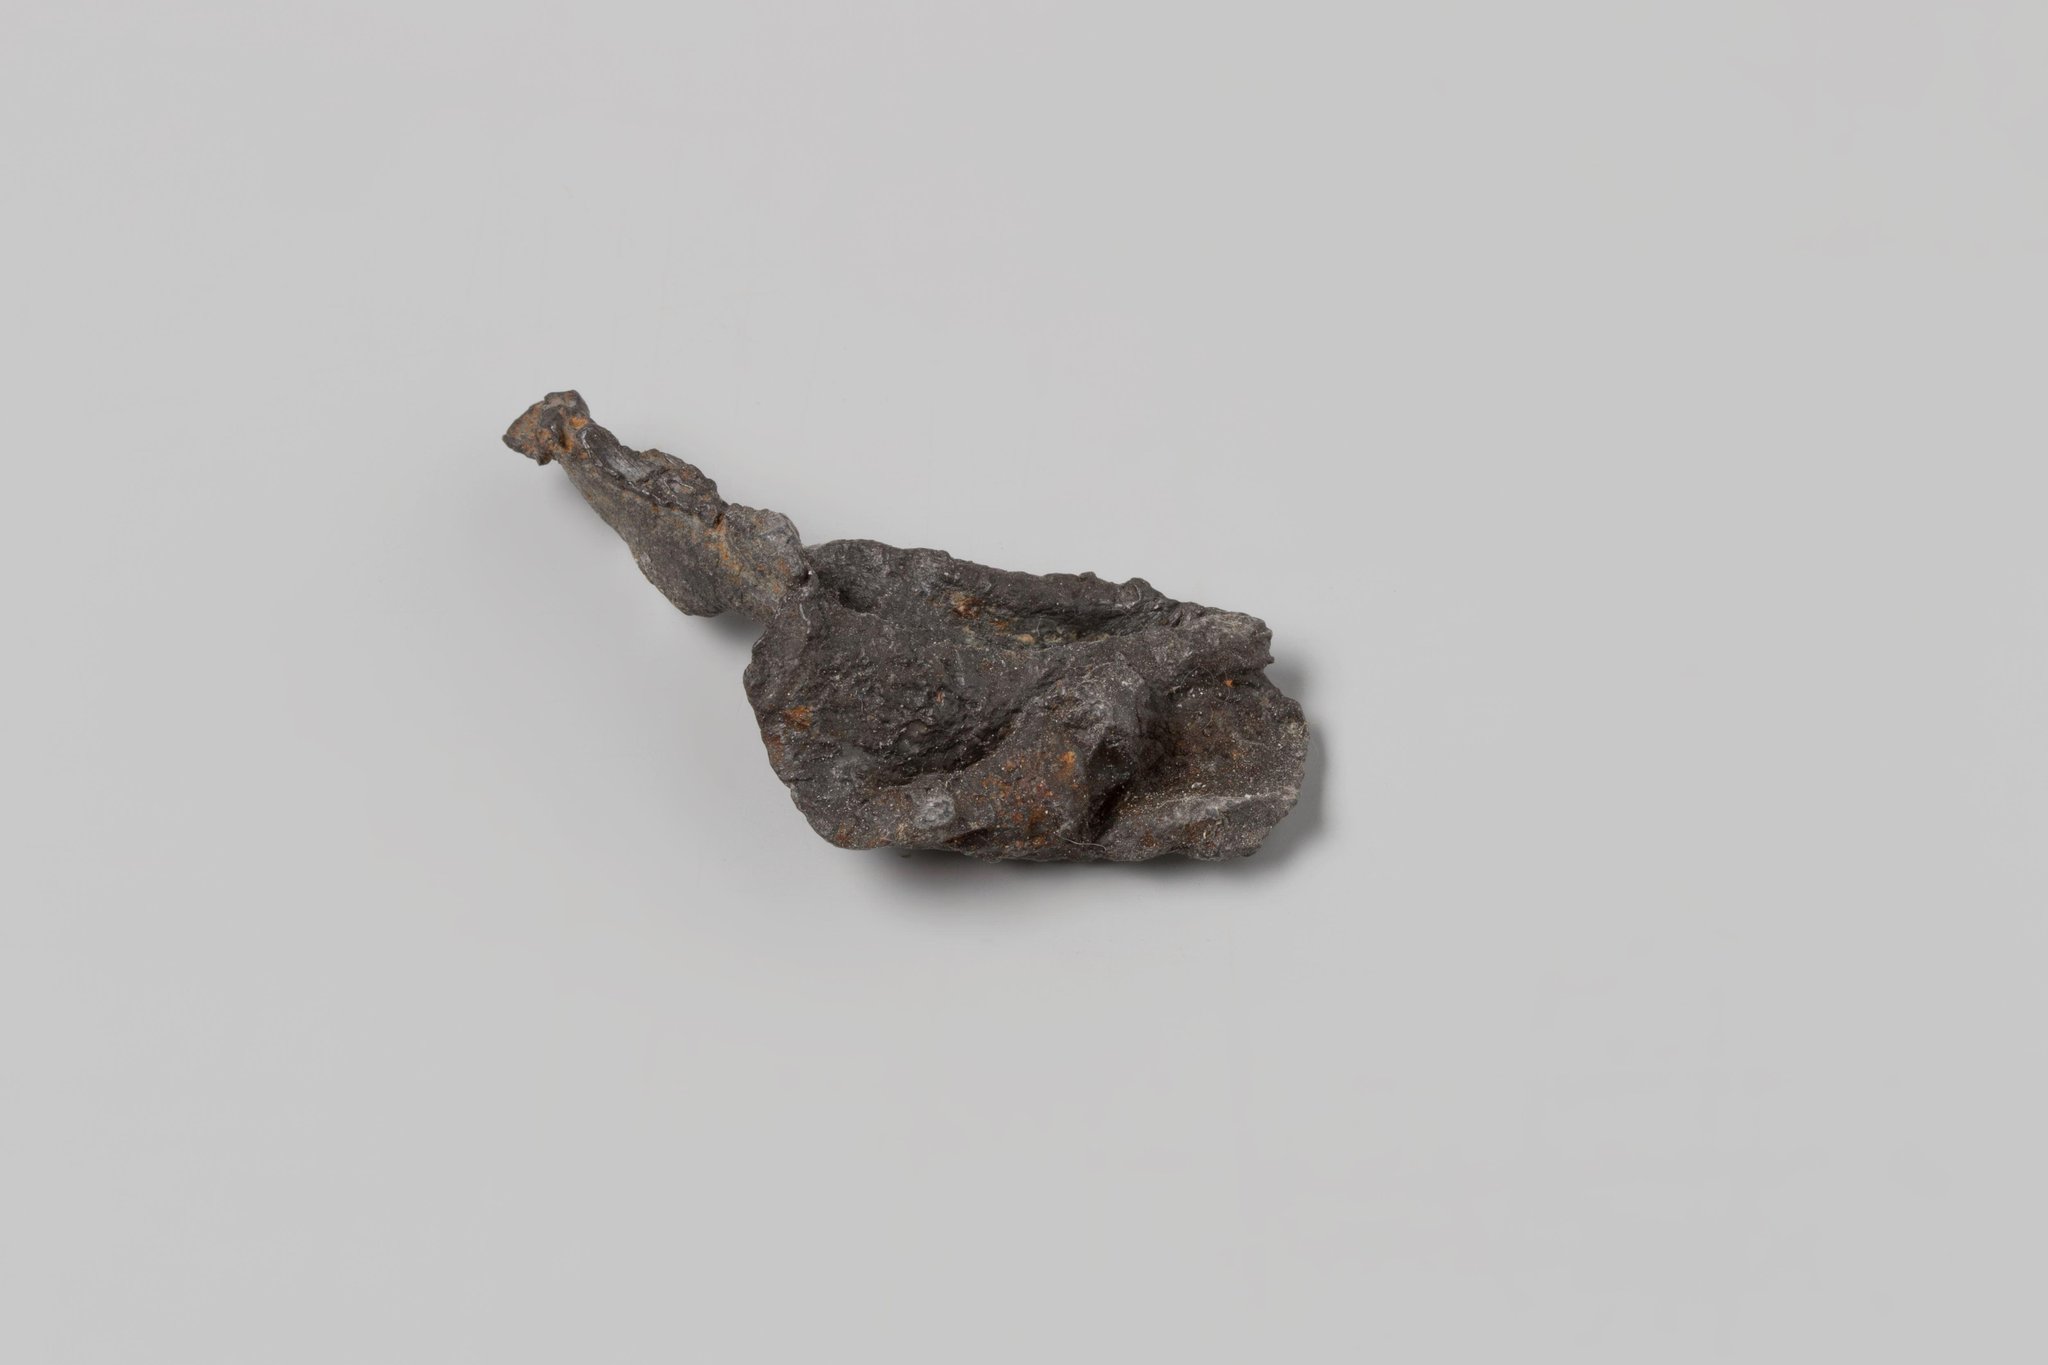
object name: fragment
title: Fragment lood uit het wrak van de Oost-Indiëvaarder Hollandia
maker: Anonymous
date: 1700-1743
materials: lead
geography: netherlands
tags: verenigde oostindische compagnie, hollandia (schip), annet